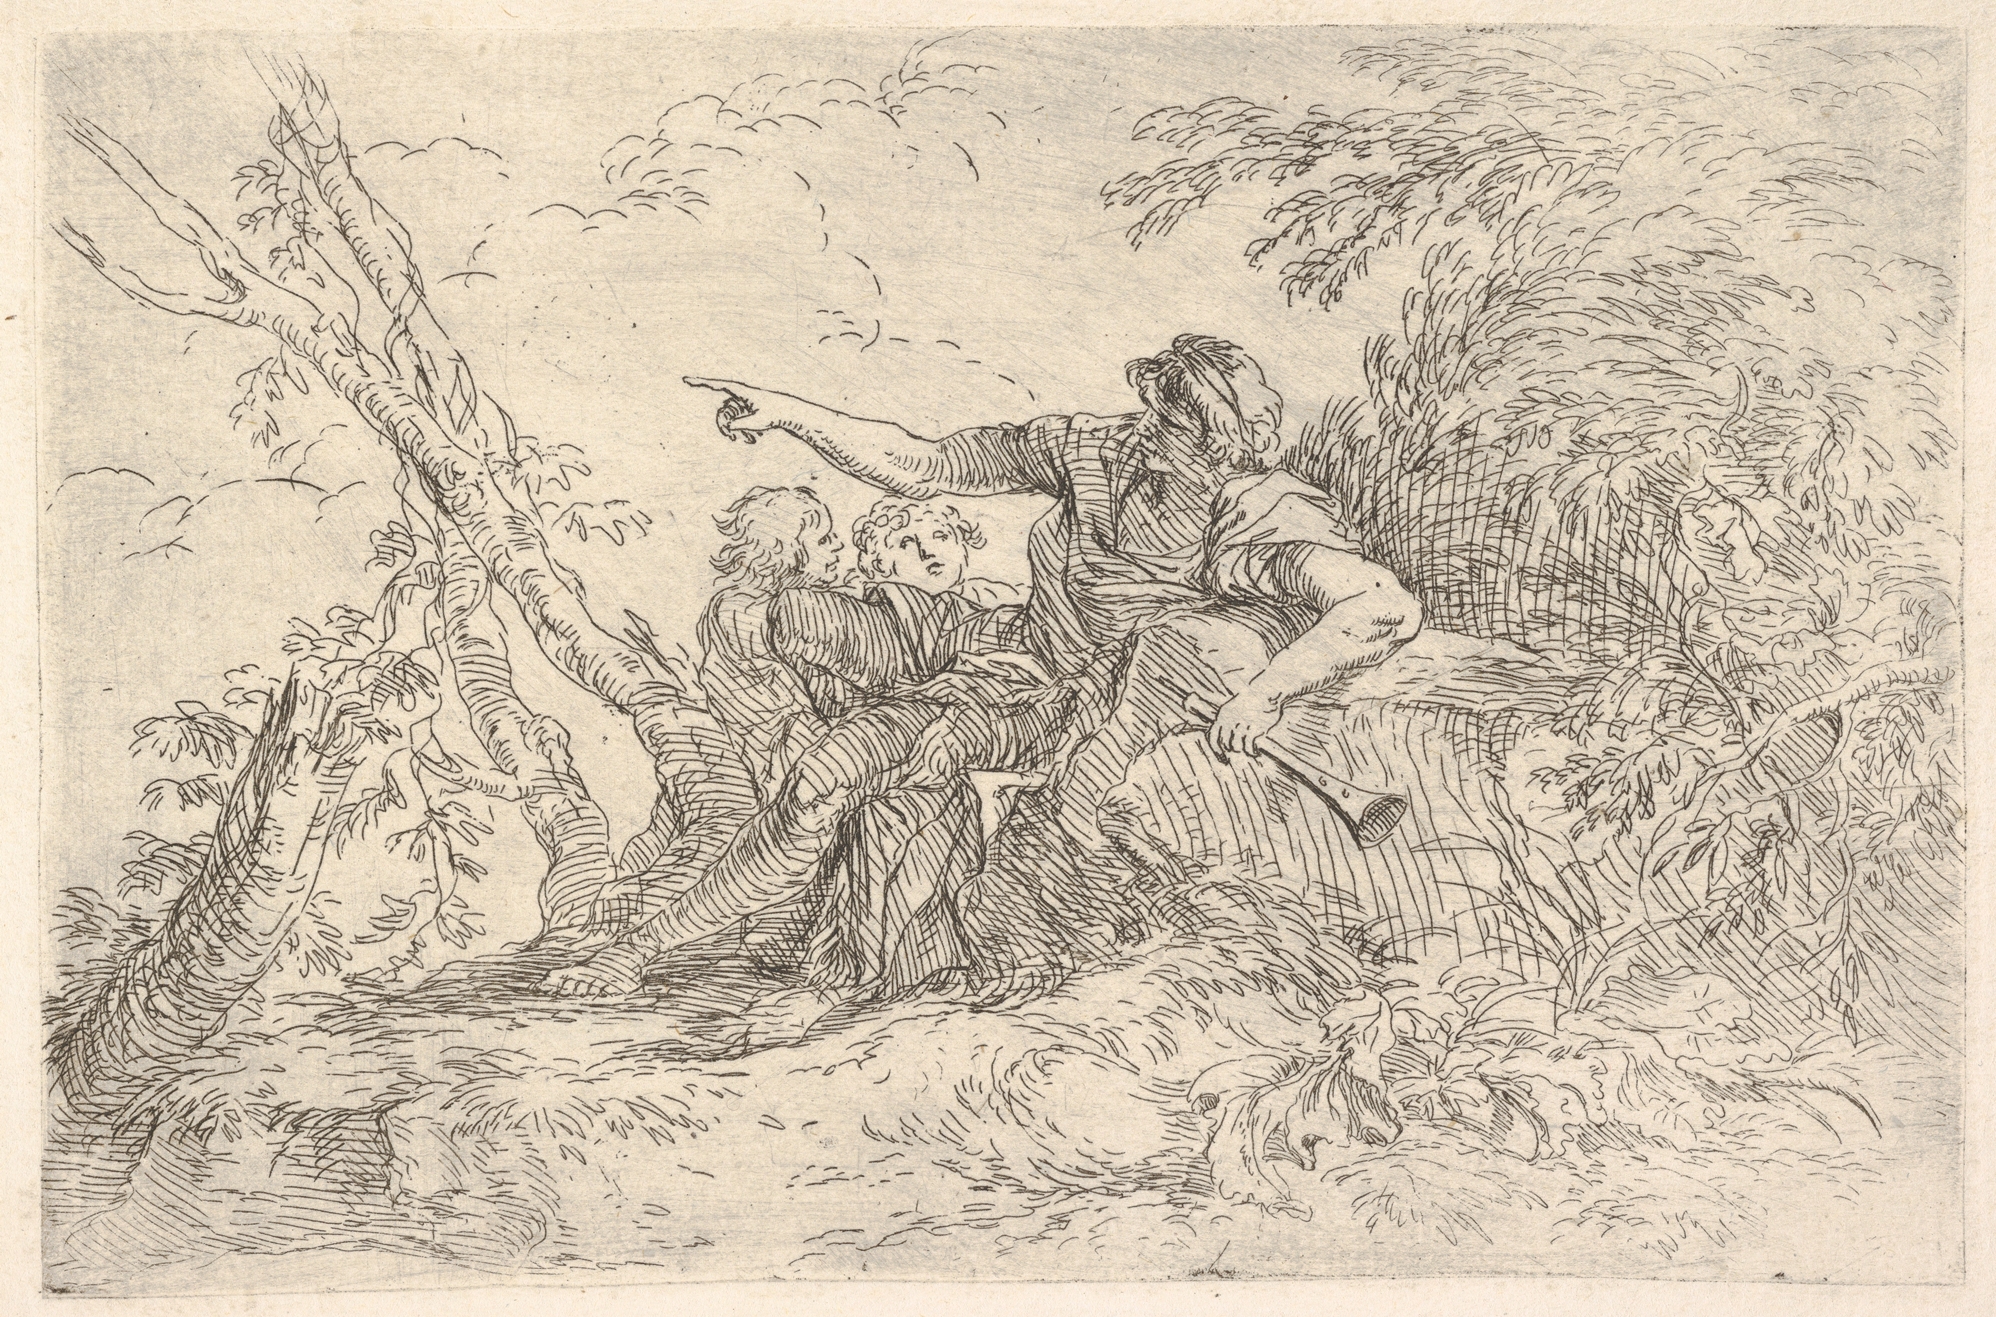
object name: print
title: Male figure holding a flute reclining on a rock and pointing over the heads of two children, from "The Triton Group"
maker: salvator rosa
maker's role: artist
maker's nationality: italian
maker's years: 1615-1673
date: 1660-1661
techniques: drypoint, etching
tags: children,men,flutes